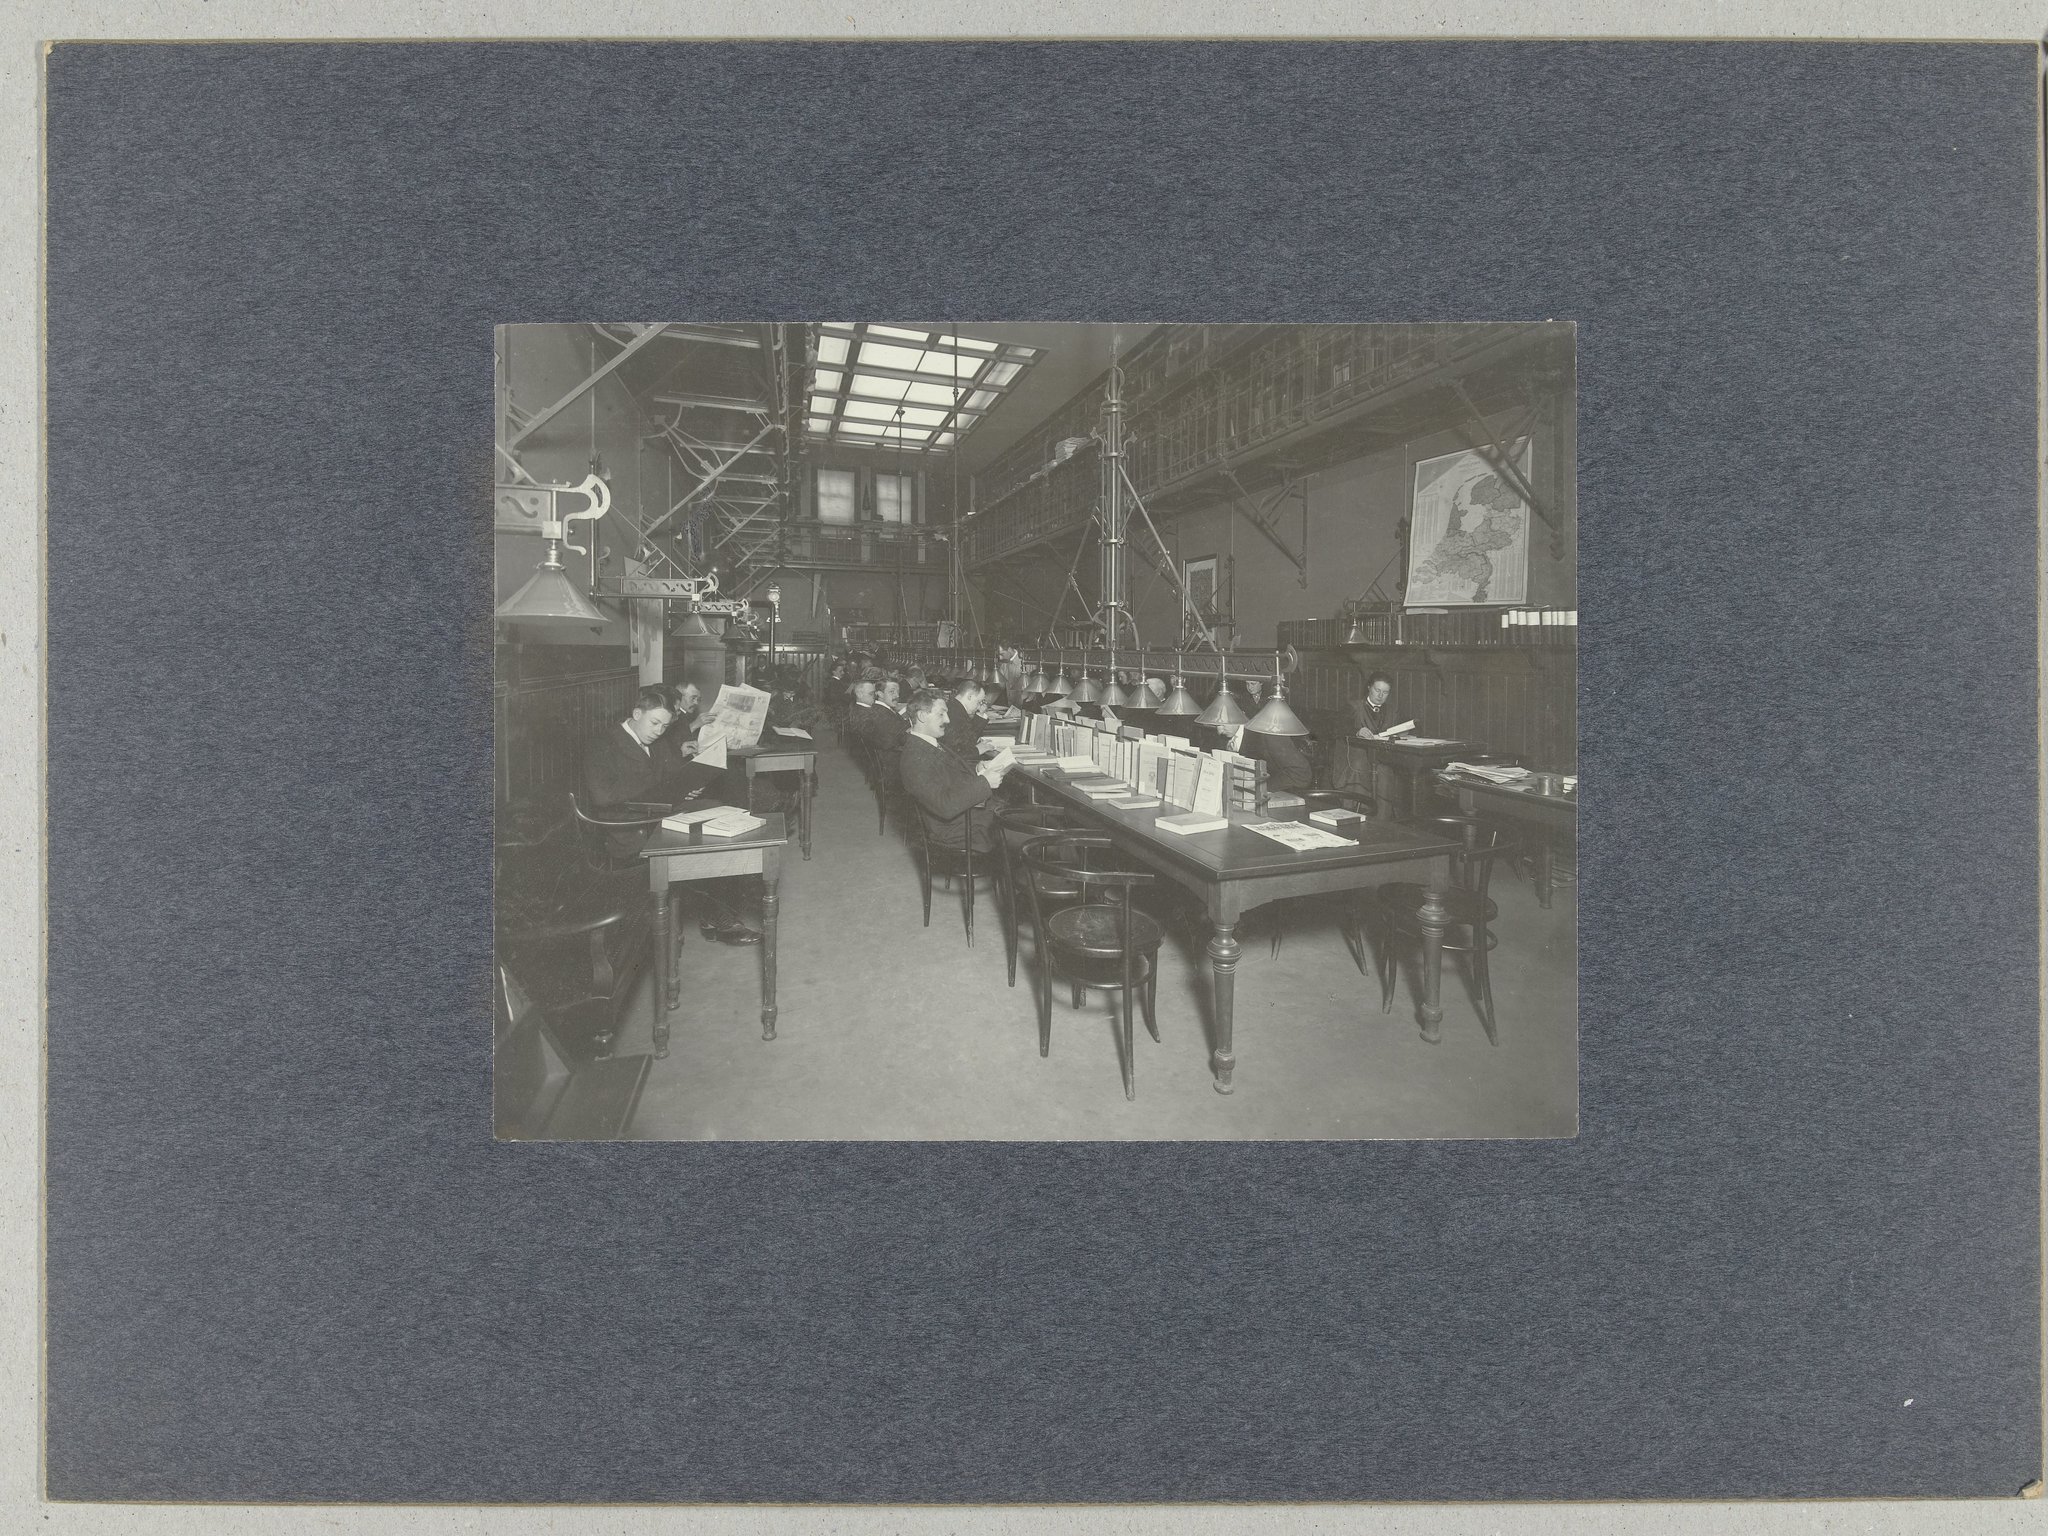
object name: photograph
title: Interieur van een leeszaal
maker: wouter cool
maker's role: engineer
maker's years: 1877-1947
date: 1911-1912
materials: paper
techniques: matte daylight collodion silver print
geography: rotterdam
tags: edifice, e.g.: public building, department store - aa - civic architecture: inside, netherlands